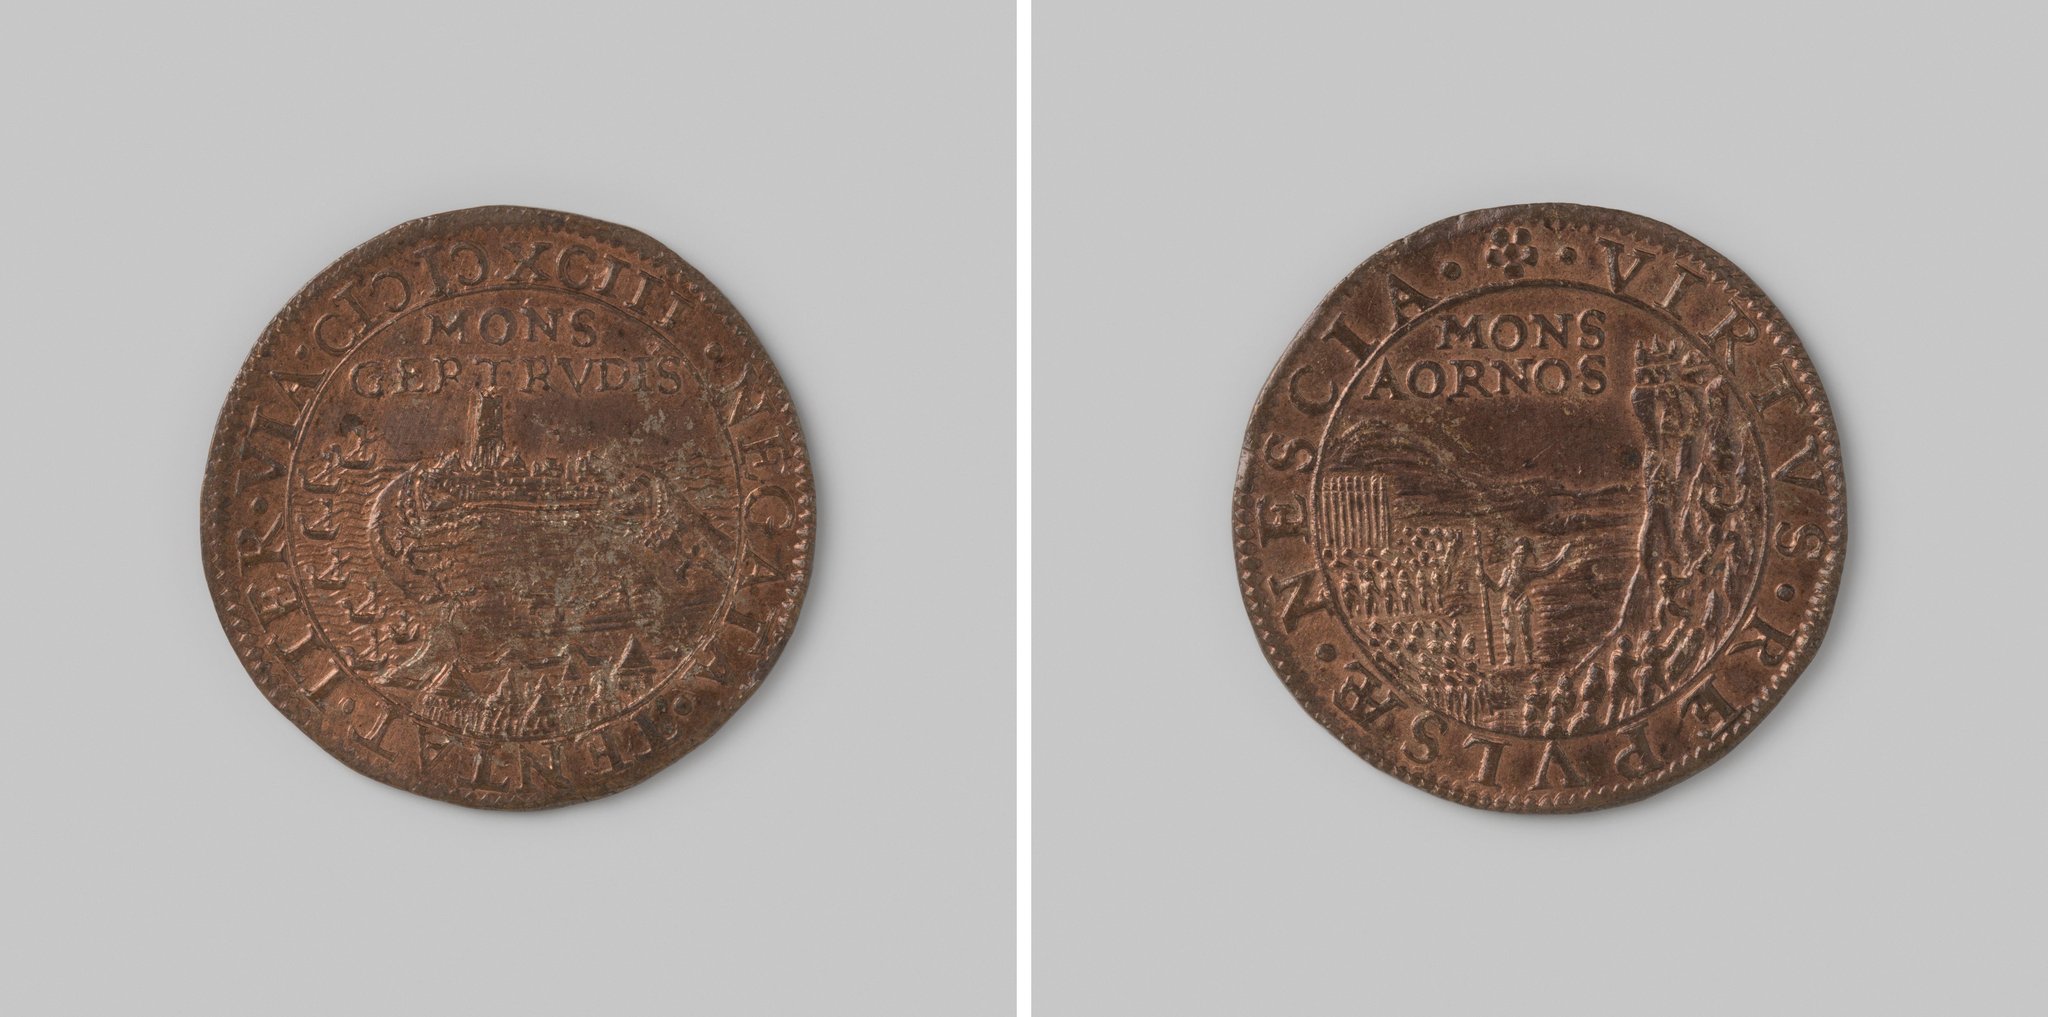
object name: history medal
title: Rekenpenning uit Dordrecht op de inname van Geertruidenberg door Prins Maurits 1593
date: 1593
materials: copper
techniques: striking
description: Koperen penning, op de voorzijde Geertruidenberg aangevallen door soldaten en schepen, met omschrift, op de keerzijde de berg Aornos door een leger beklommen, met omschrift.